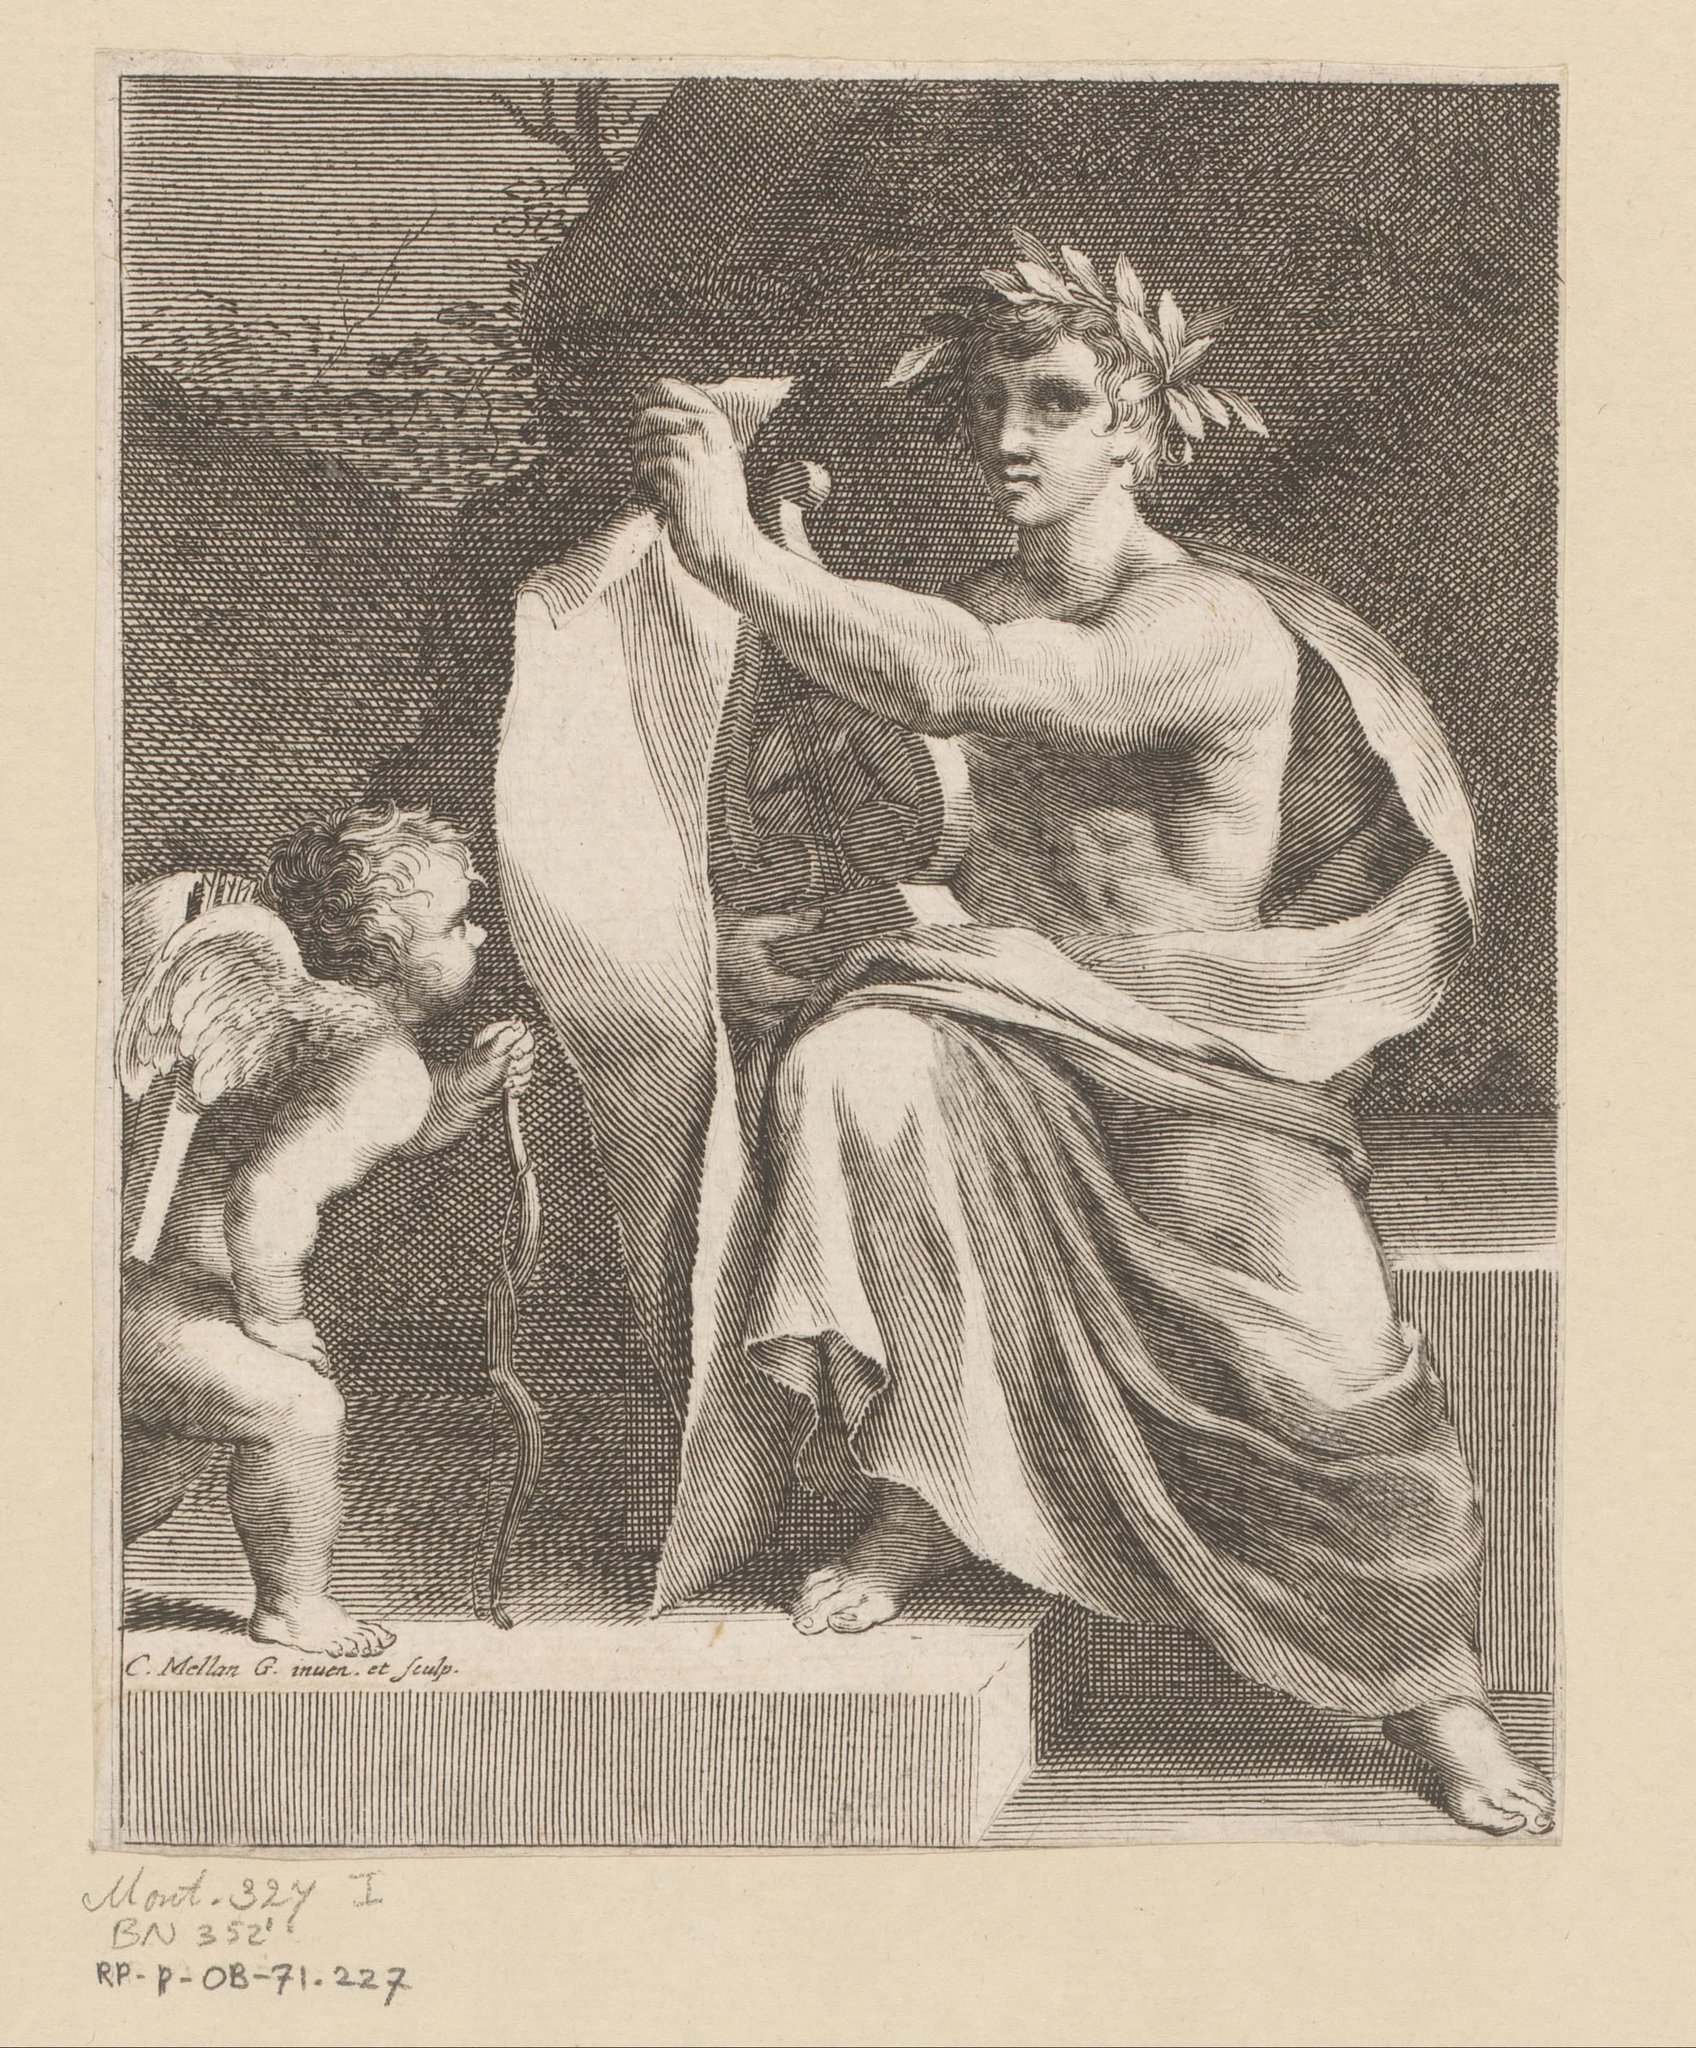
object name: titelblad, titelpagina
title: Titelpagina voor: François Tristan l'Hermite sieur du Soliers, Les Amours de Tristan, 1638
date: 1638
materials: paper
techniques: engraving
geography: paris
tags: (story of) apollo (phoebus)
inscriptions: collector's mark: Lugt 240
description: Titelpagina voor: l'Hermite sieur du Soliers, François Tristan. Les Amours de Tristan. Parijs: Pierre Billaine en Augustin Courbé, 1638.